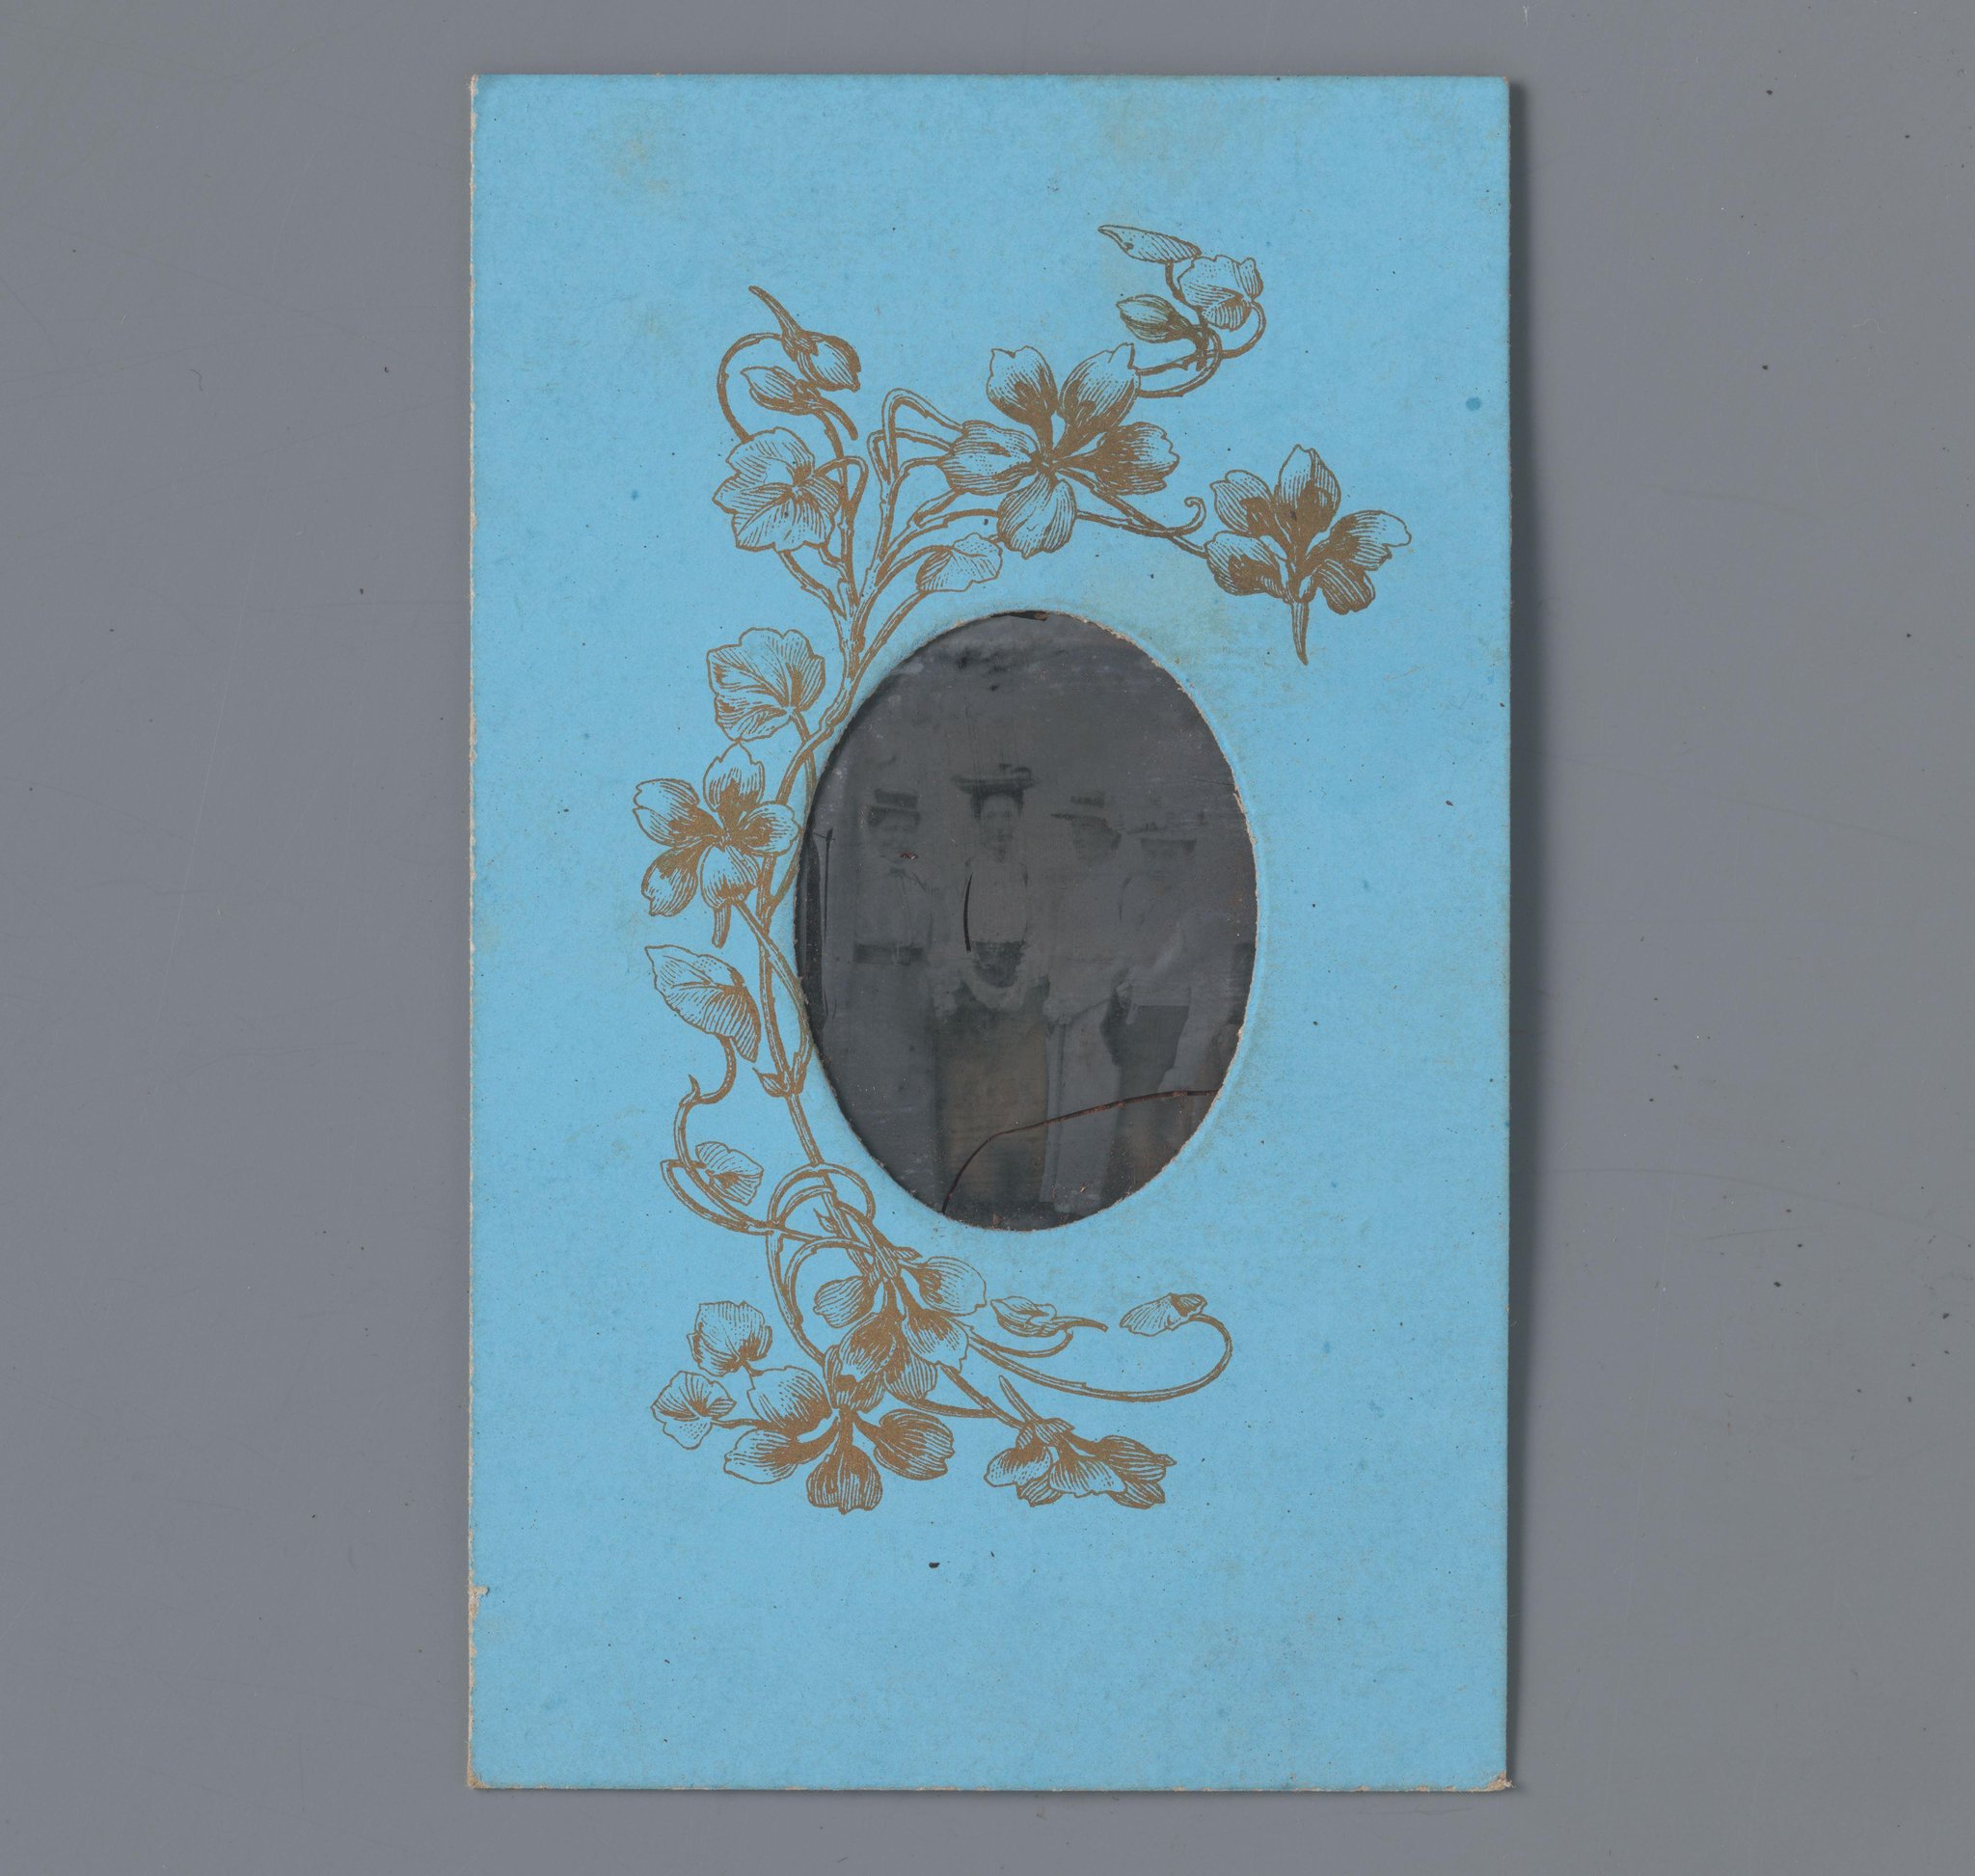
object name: photograph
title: Groepsportret van vier vrouwen met hoeden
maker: Anonymous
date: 1855-1900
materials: cardboard, iron, paper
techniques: ferrotyping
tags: anonymous historical persons portrayed in a group, in a group-portrait - bb - woman, head-gear: hat